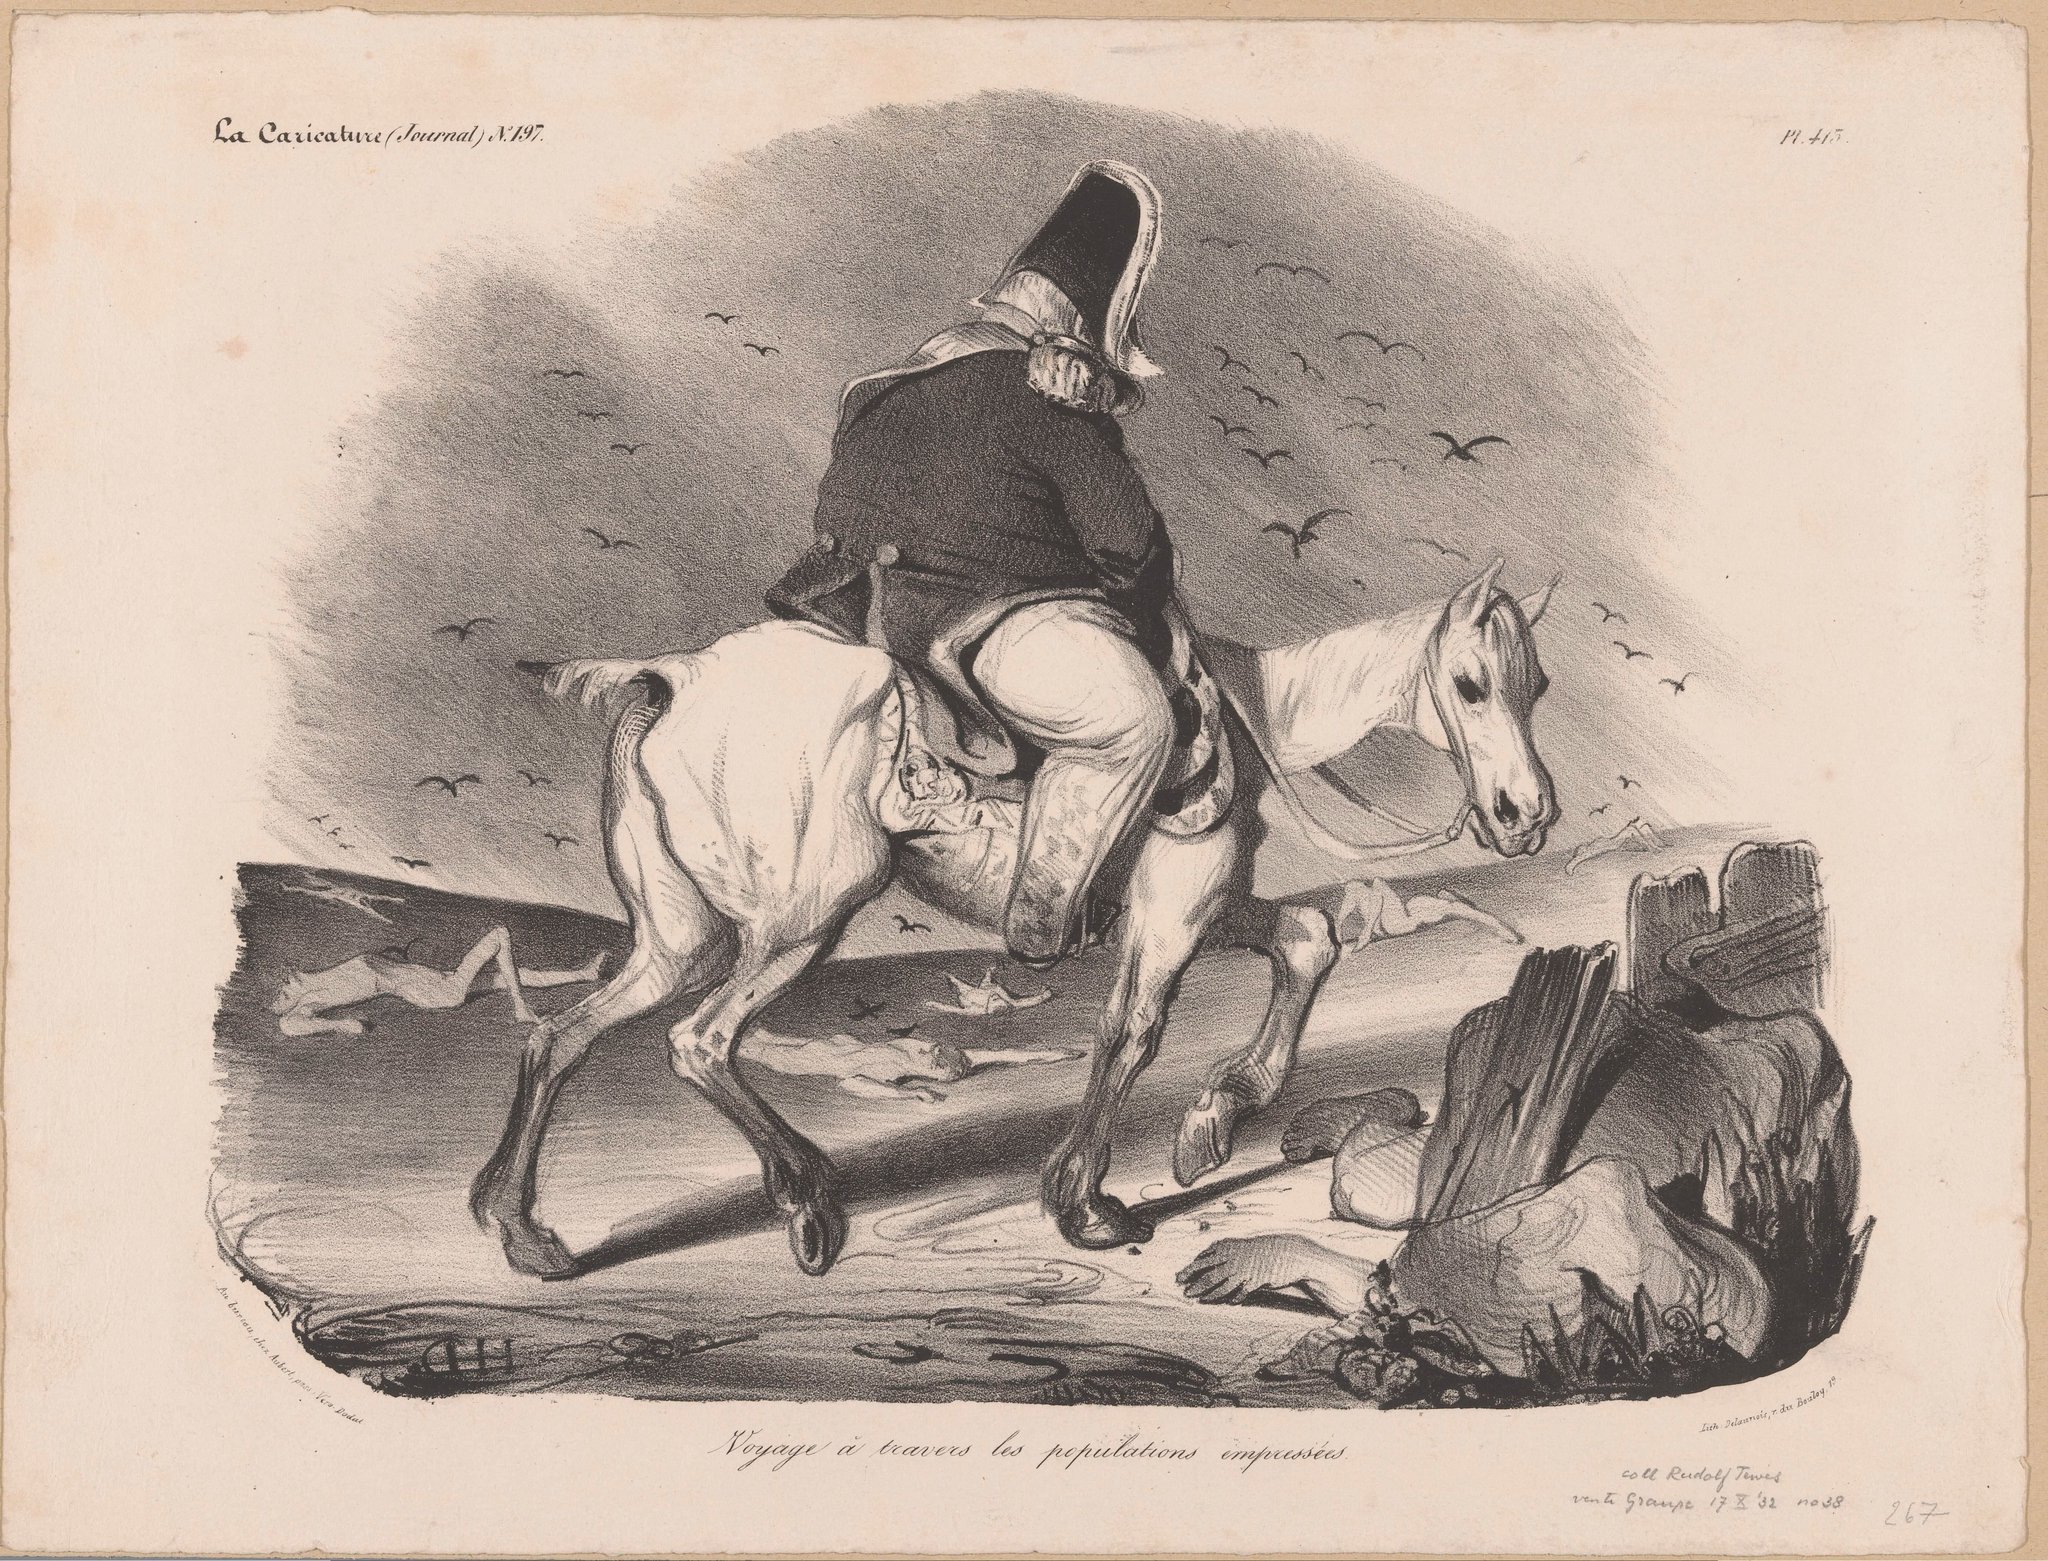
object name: cartoon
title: Voyage à travers les populations empressées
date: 1834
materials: paper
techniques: lithograph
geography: paris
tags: lodewijk filips i (koning van frankrijk), caricatures (human types), historical persons, the corpse, horse, political caricatures and satires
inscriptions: collector's mark: Lugt 2228a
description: Prent gepubliceerd in: La Caricature, 14 september 1834, nr. 197, pl. 413.